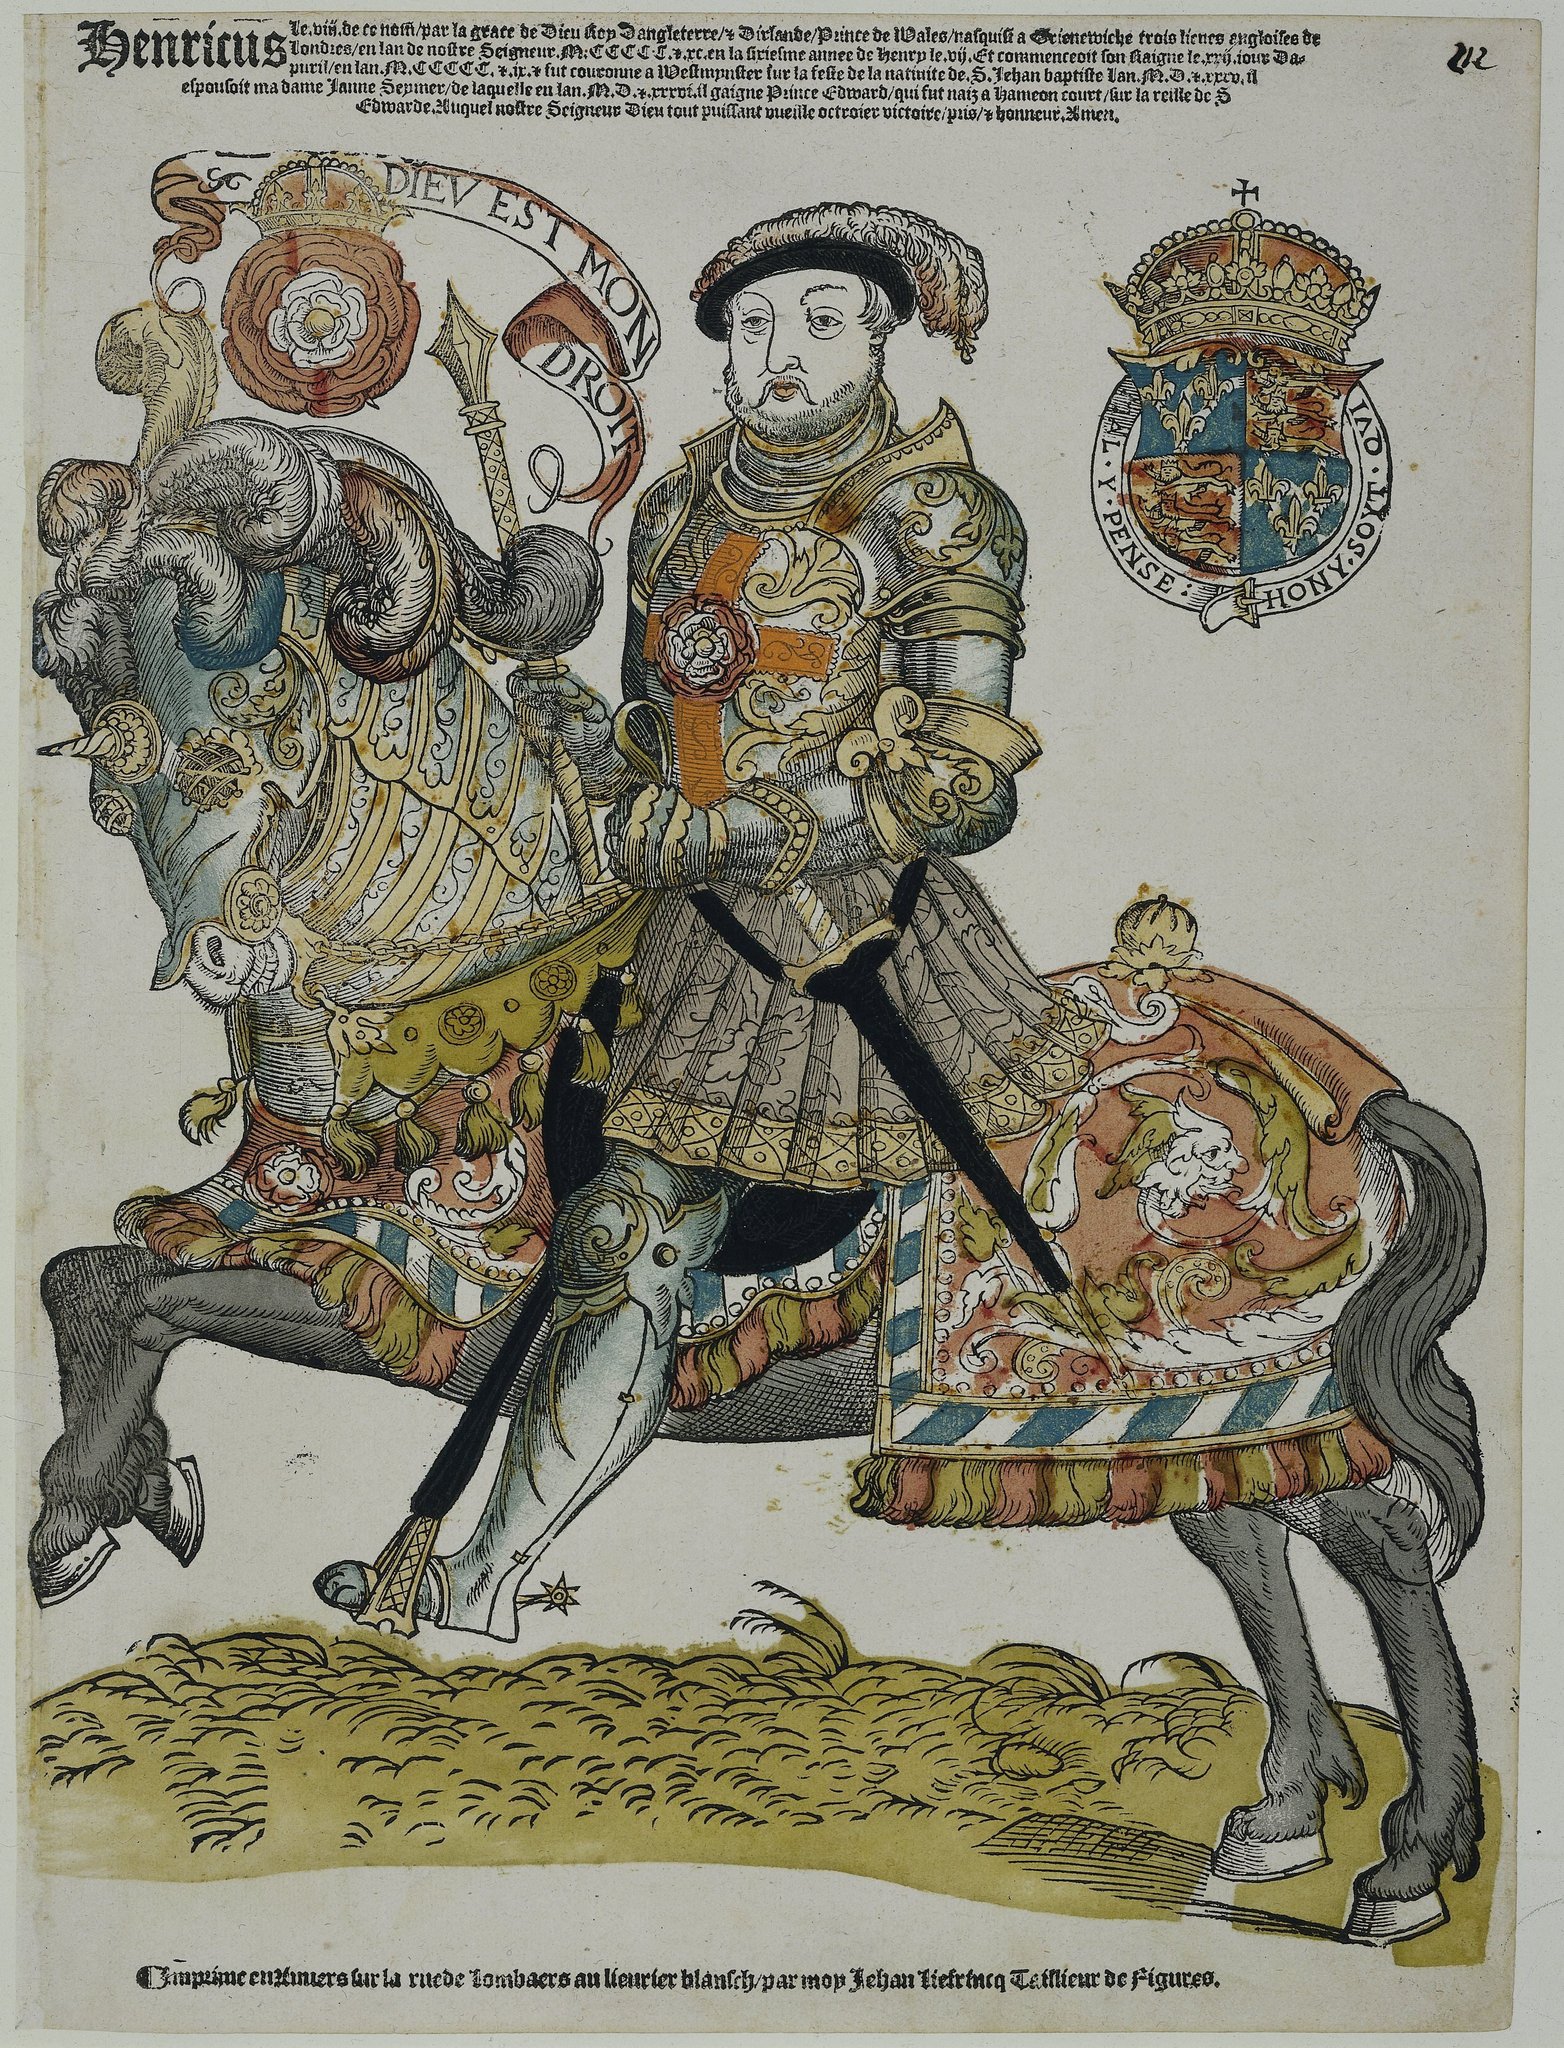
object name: print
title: Portret van Hendrik VIII van Engeland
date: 1539-1547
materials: paper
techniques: hand coloring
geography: antwerp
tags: equestrian state-portrait, king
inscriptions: number: ‘212’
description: Portret van Hendrik VIII van Engeland te paard. Hij doet denken aan zijn bijnaam 'Novus Constantinus'. Ruiter en paard in wapenrusting. Rechtsboven het Engelse wapen met de Orde van de Kousenband, linksboven de Rozen van Lancaster en York in elkaar en het devies DIEV EST MON DROIT op een spreukband. Vijf regels tekst in het Frans boven de afbeelding en één er onder.